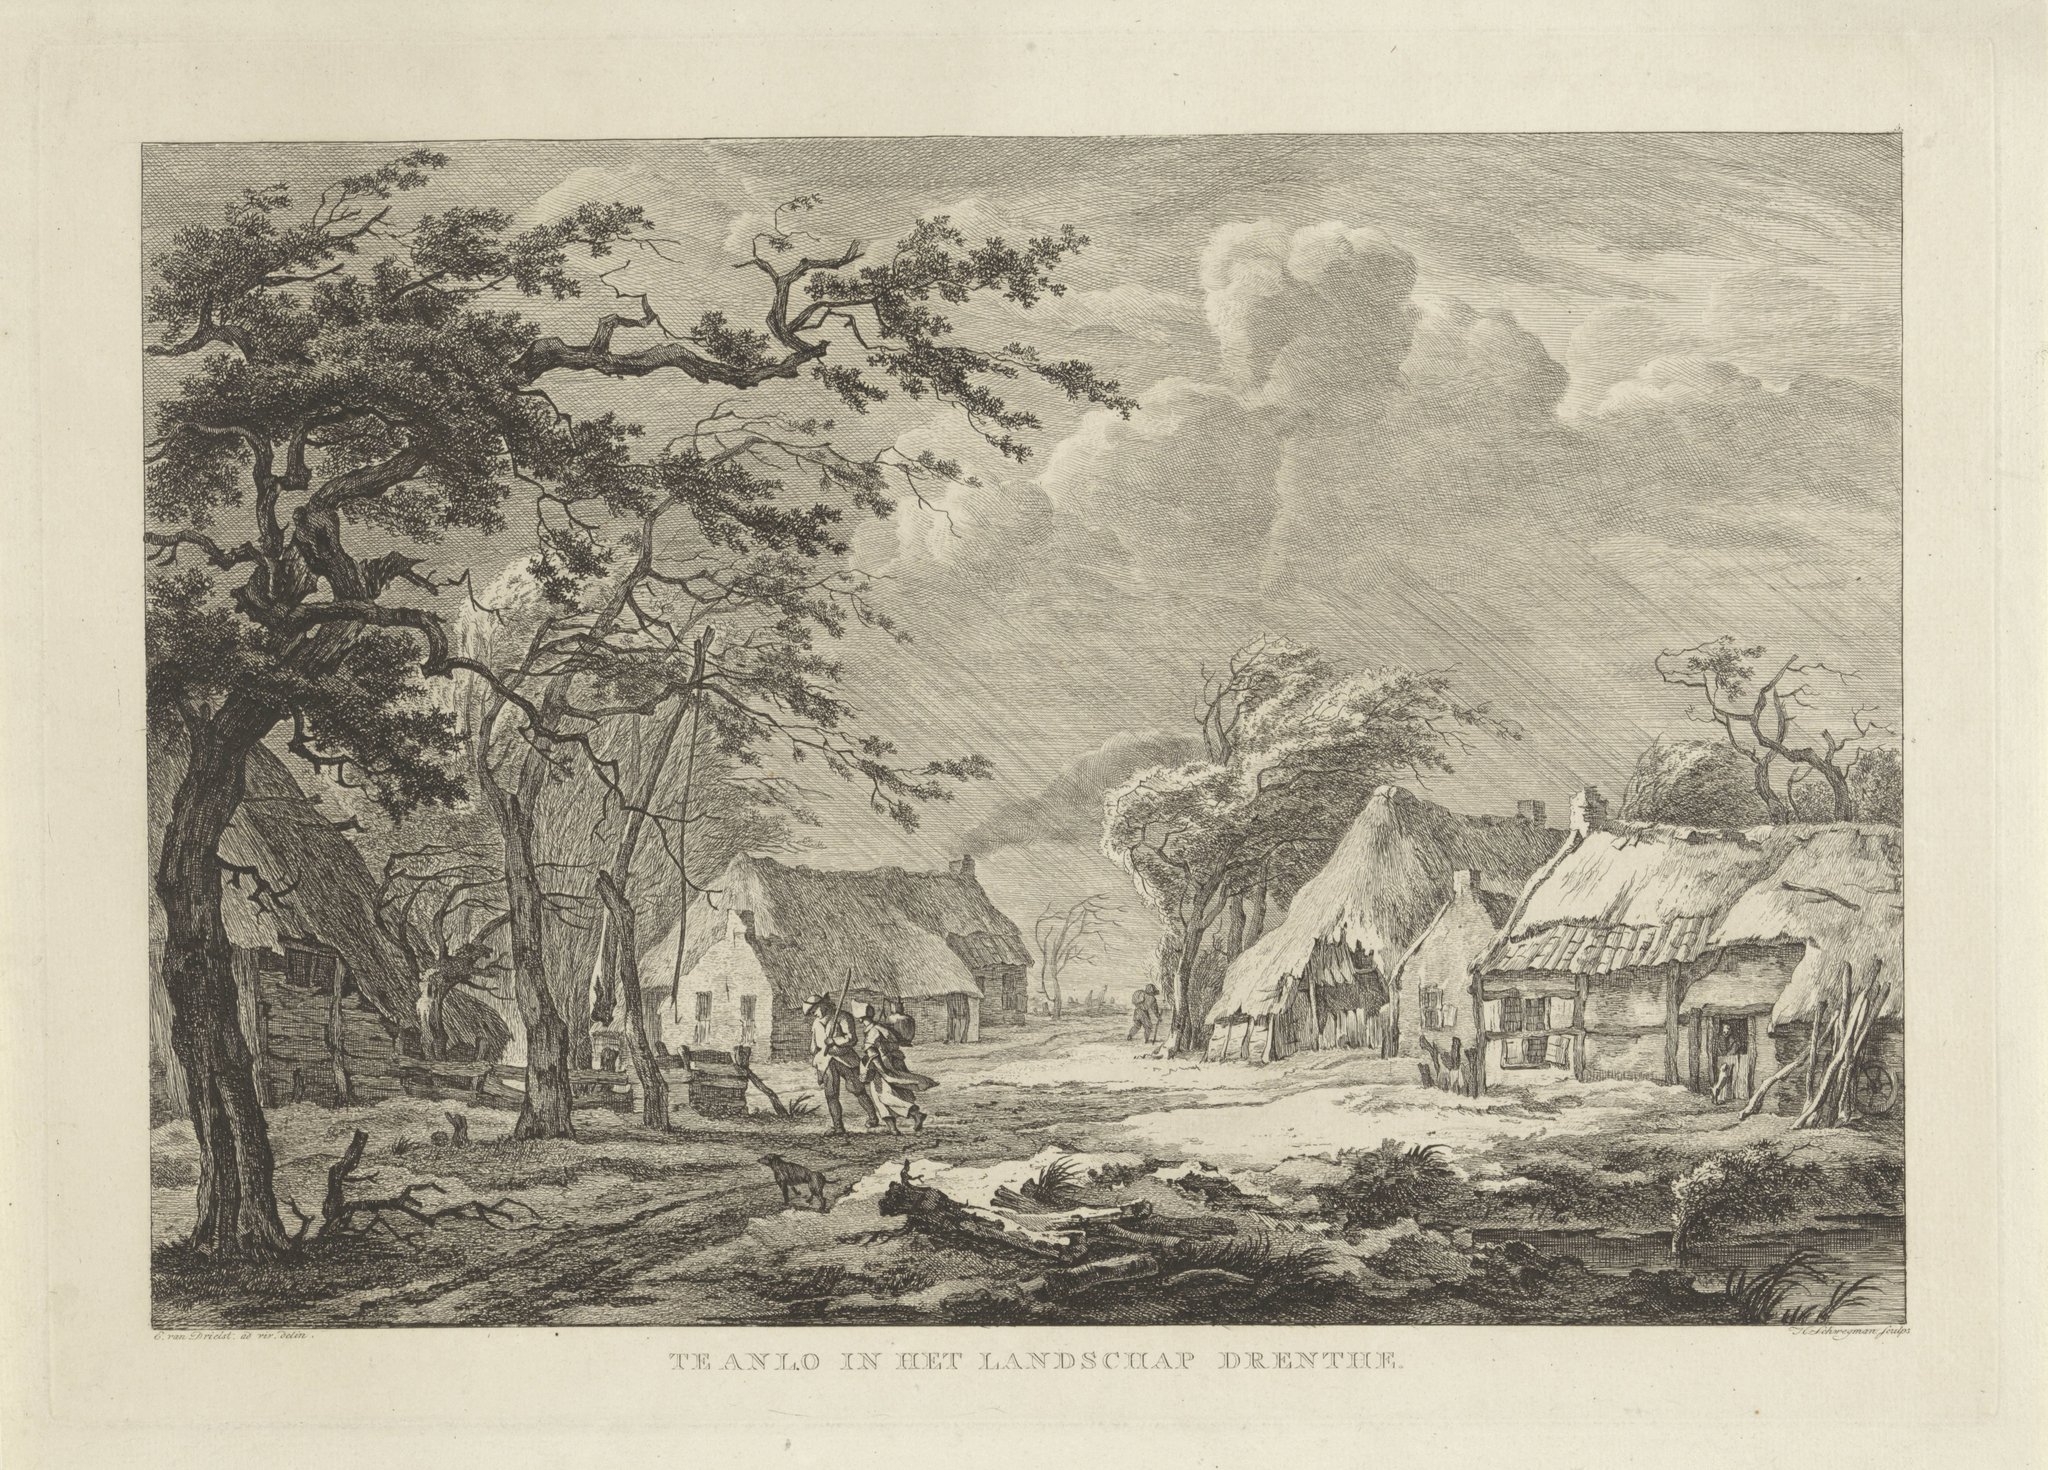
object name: print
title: IX Gezichten in en bij het landschap Drenthe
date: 1771-1816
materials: paper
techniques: engraving, etching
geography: anloo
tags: village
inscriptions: collector's mark: Lugt 2228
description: Gezicht op enkele boerderijen in Anloo, Drenthe, terwijl het regent en waait. Op de voorgrond een man, vrouw en hond.